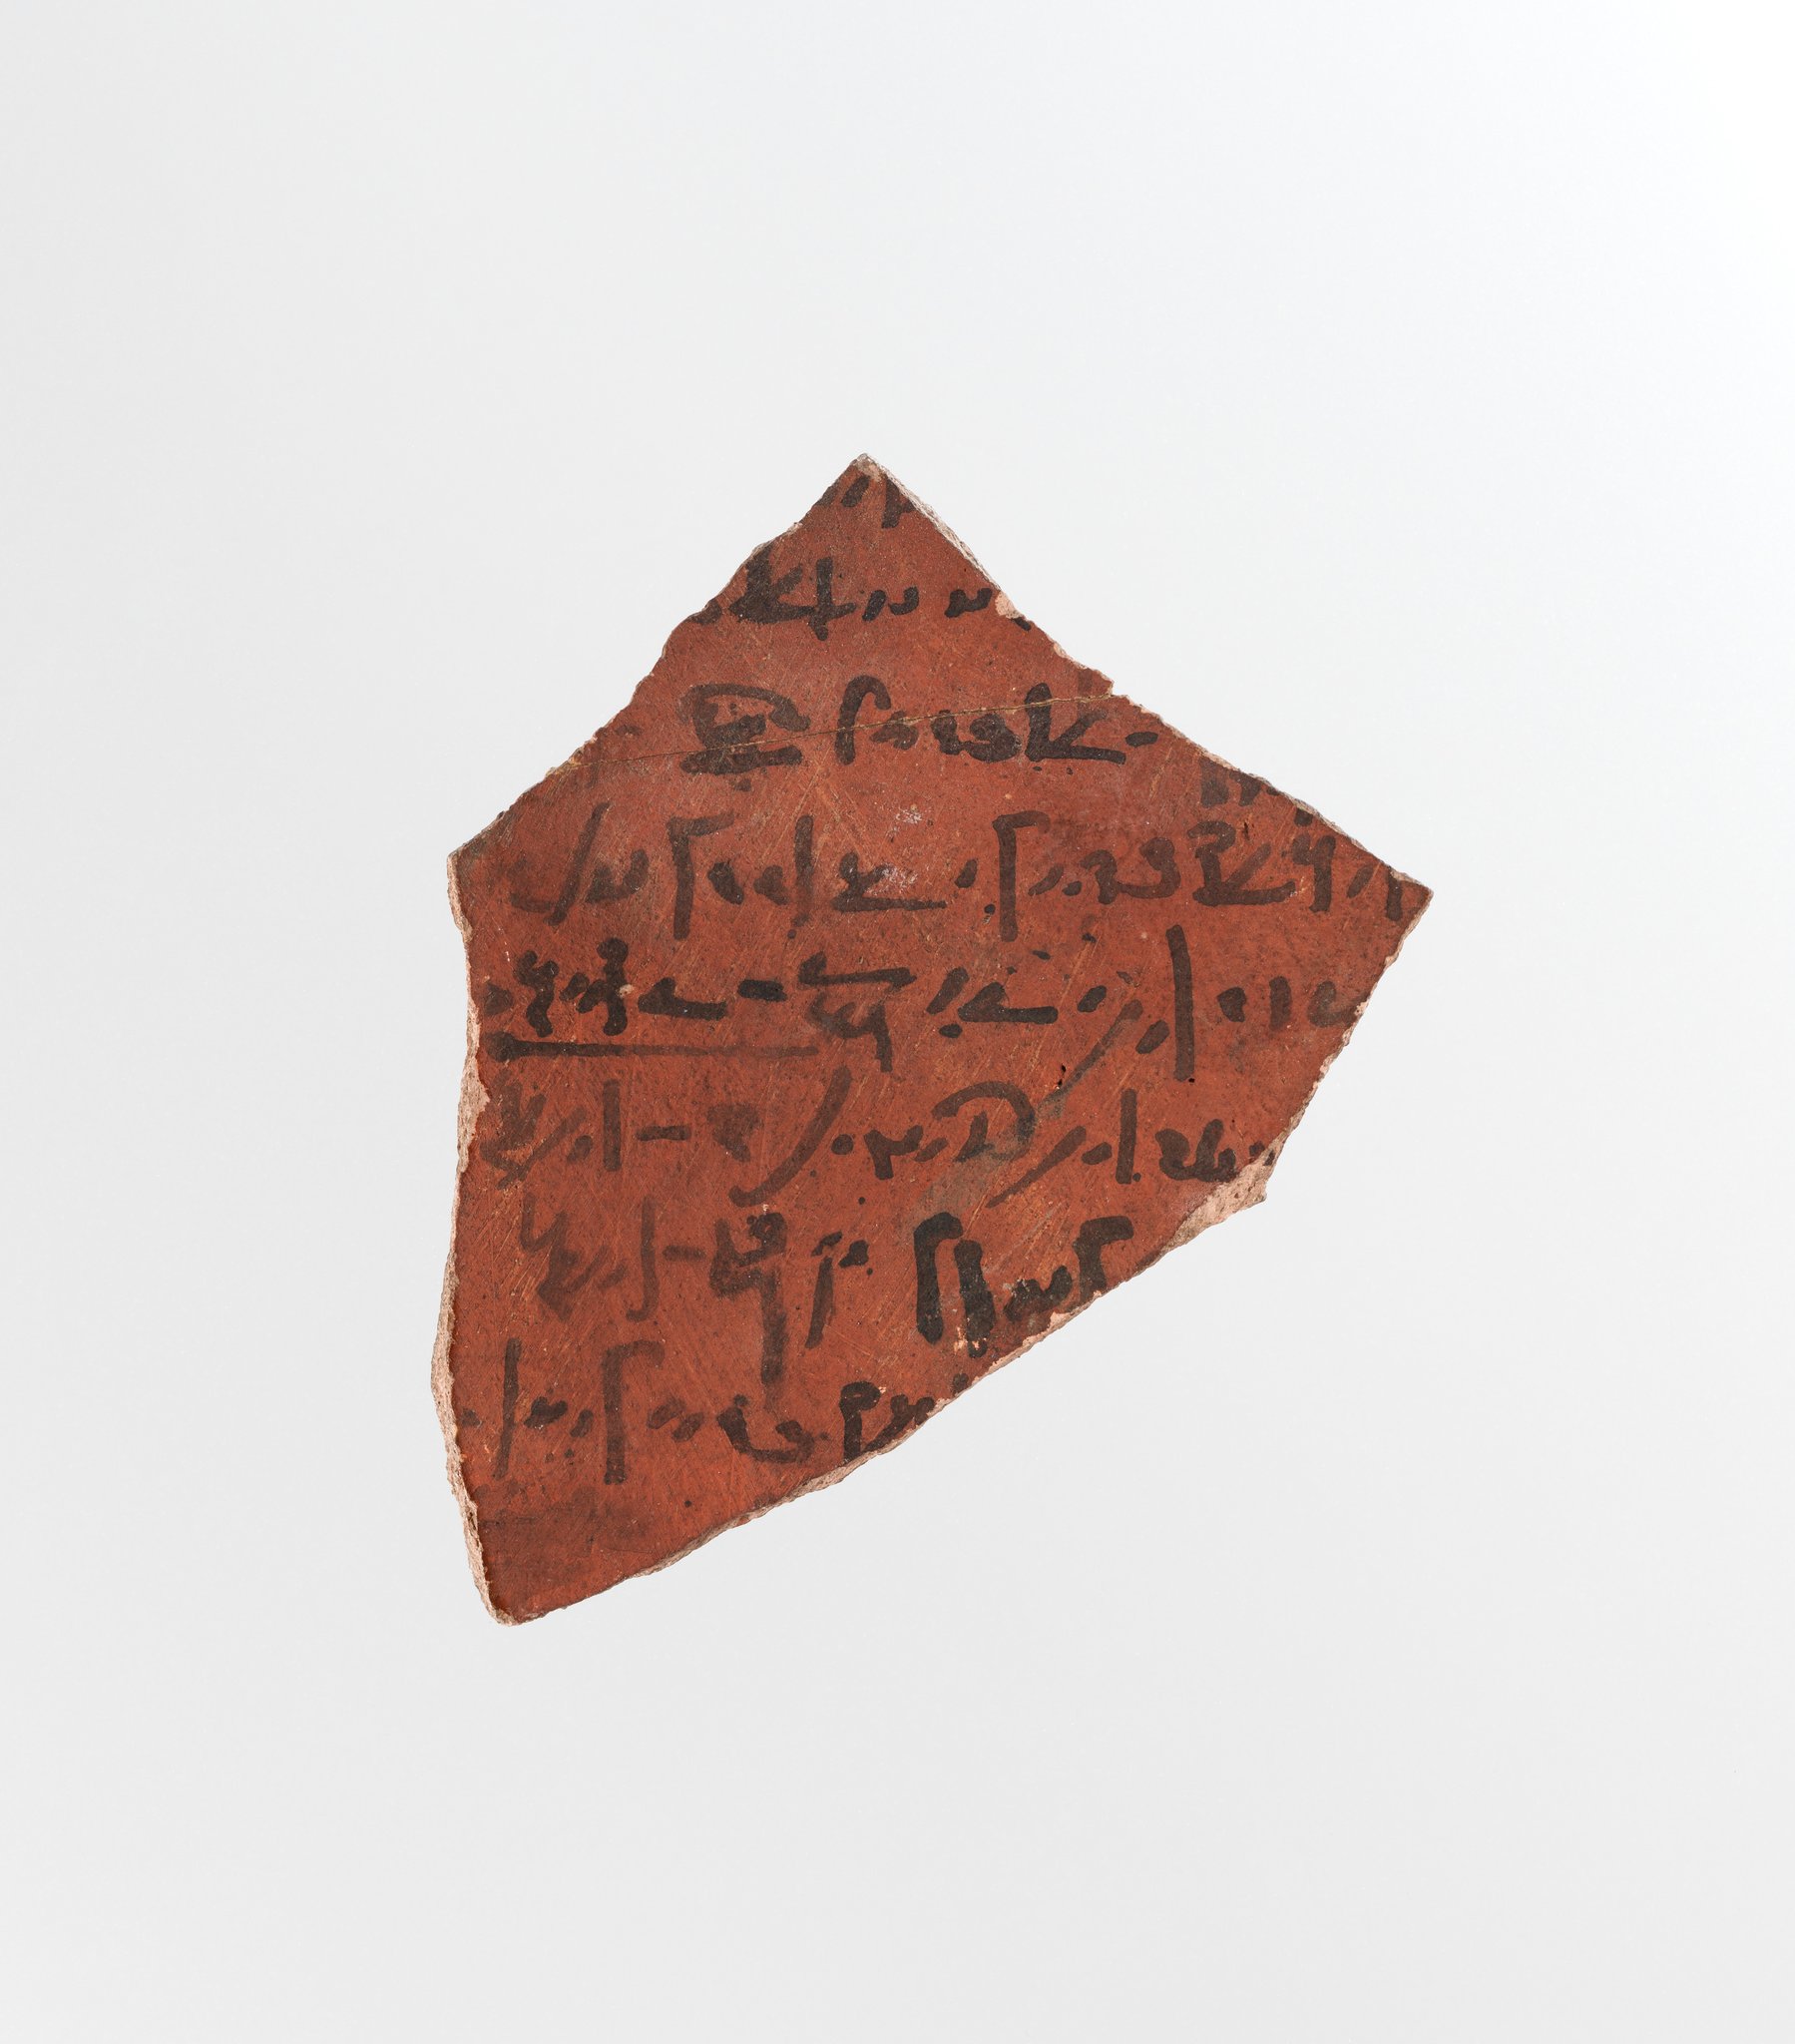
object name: ostracon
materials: ink, pottery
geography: egypt